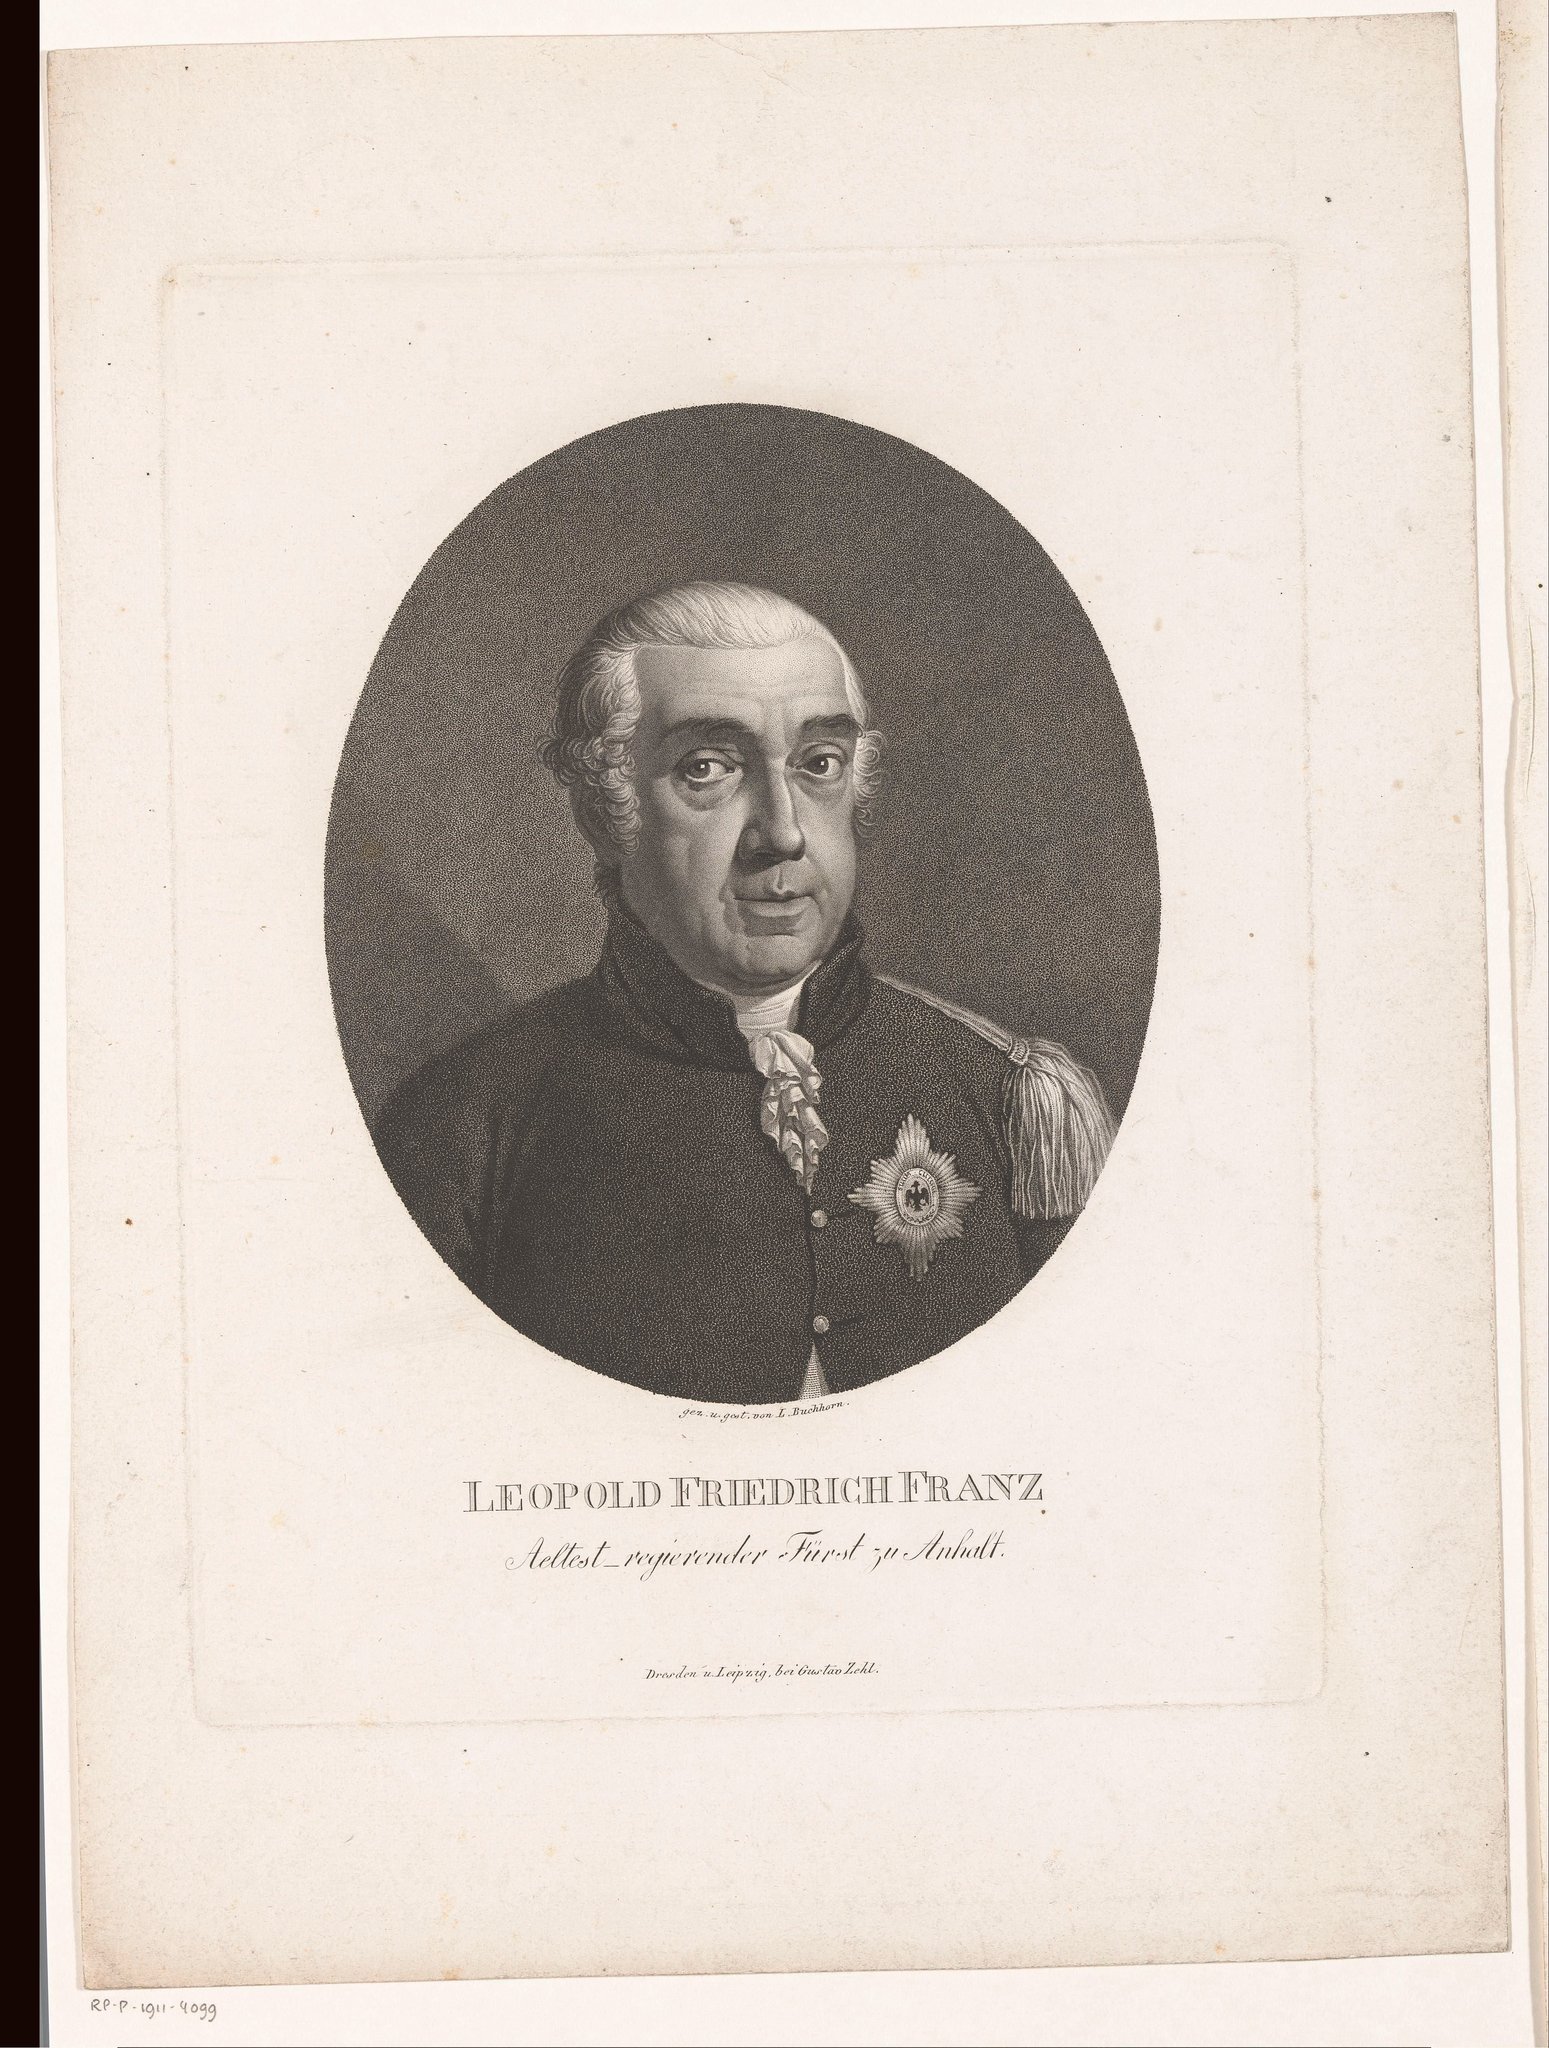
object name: print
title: Portret van Leopold III Friedrich Franz von Anhalt-Dessau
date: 1802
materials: paper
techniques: stippling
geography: dessau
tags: leopold iii frederik frans van anhalt-dessau, knighthood order (with name) - insignia of a knighthood order, e.g.: badge, chain (with name of order), historical persons, (military) uniforms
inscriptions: collector's mark: Lugt 2228